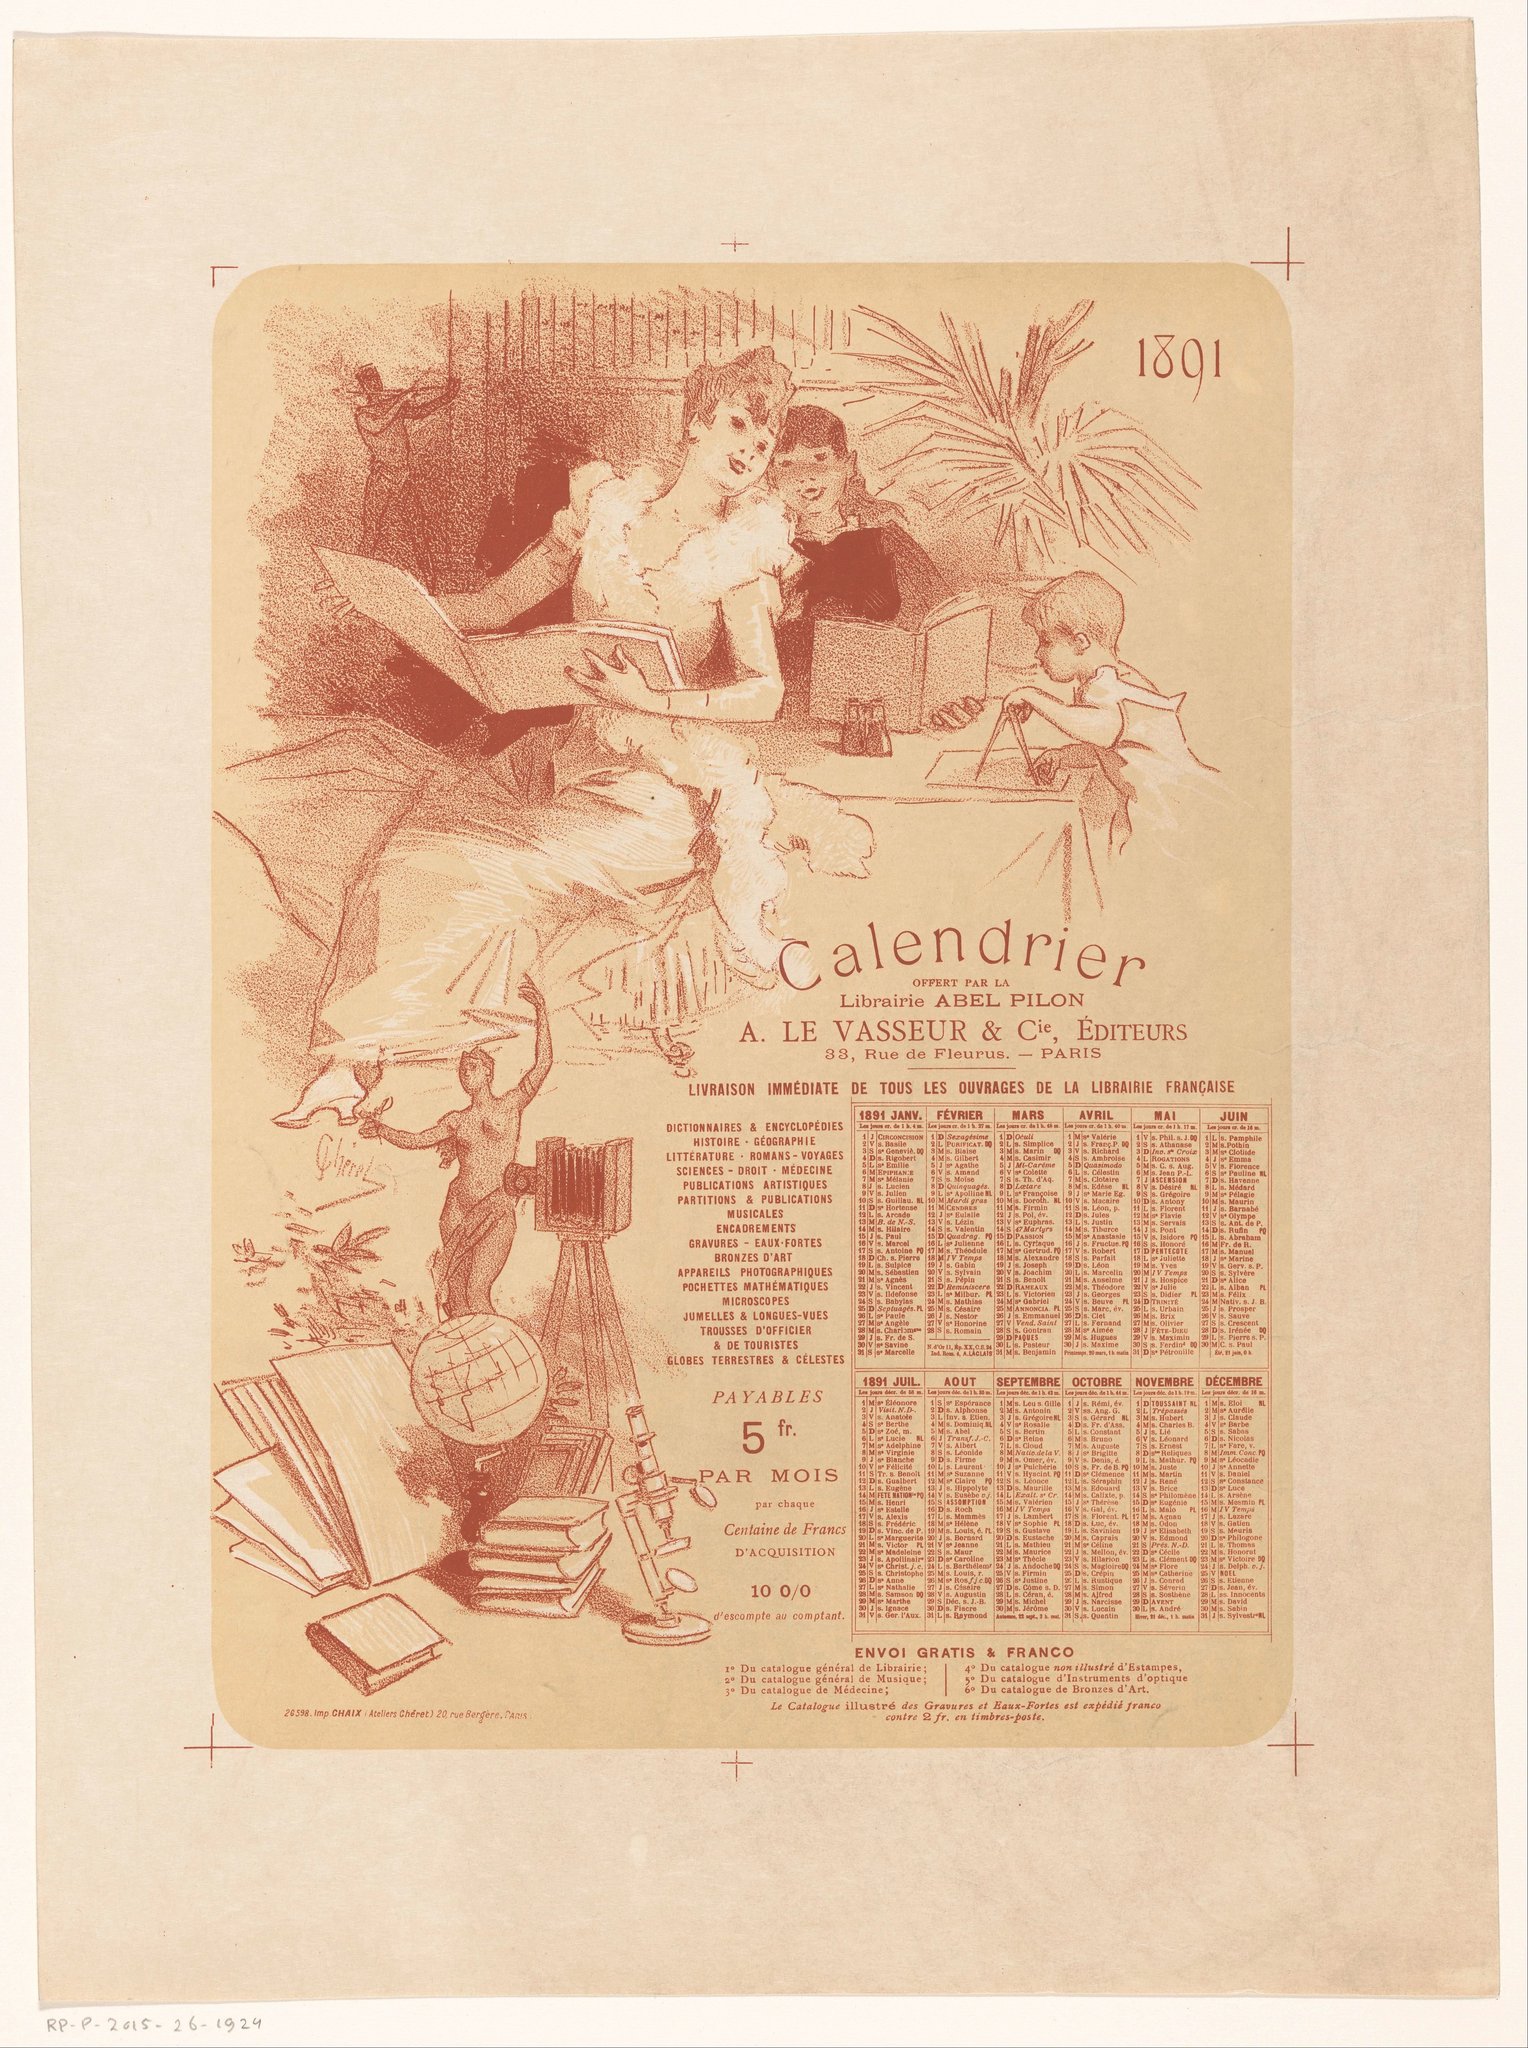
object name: print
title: Kalender van boekhandel Abel Pilon en uitgeverij A. Le Vasseur & Cie voor het jaar 1891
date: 1890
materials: paper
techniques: tone lithography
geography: paris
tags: calendar, almanac, reading, camera ~ photography, globe, microscope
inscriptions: collector's mark: Lugt 4779, collector's mark: Lugt 2228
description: Aan een tafel zitten twee vrouwen met opengeslagen boeken in hun handen. Op de hoek van de tafel zit een meisje met een passer. Onder een stilleven bestaand uit een fototoestel, een microscoop, een globe, een beeld en een stapel boeken.